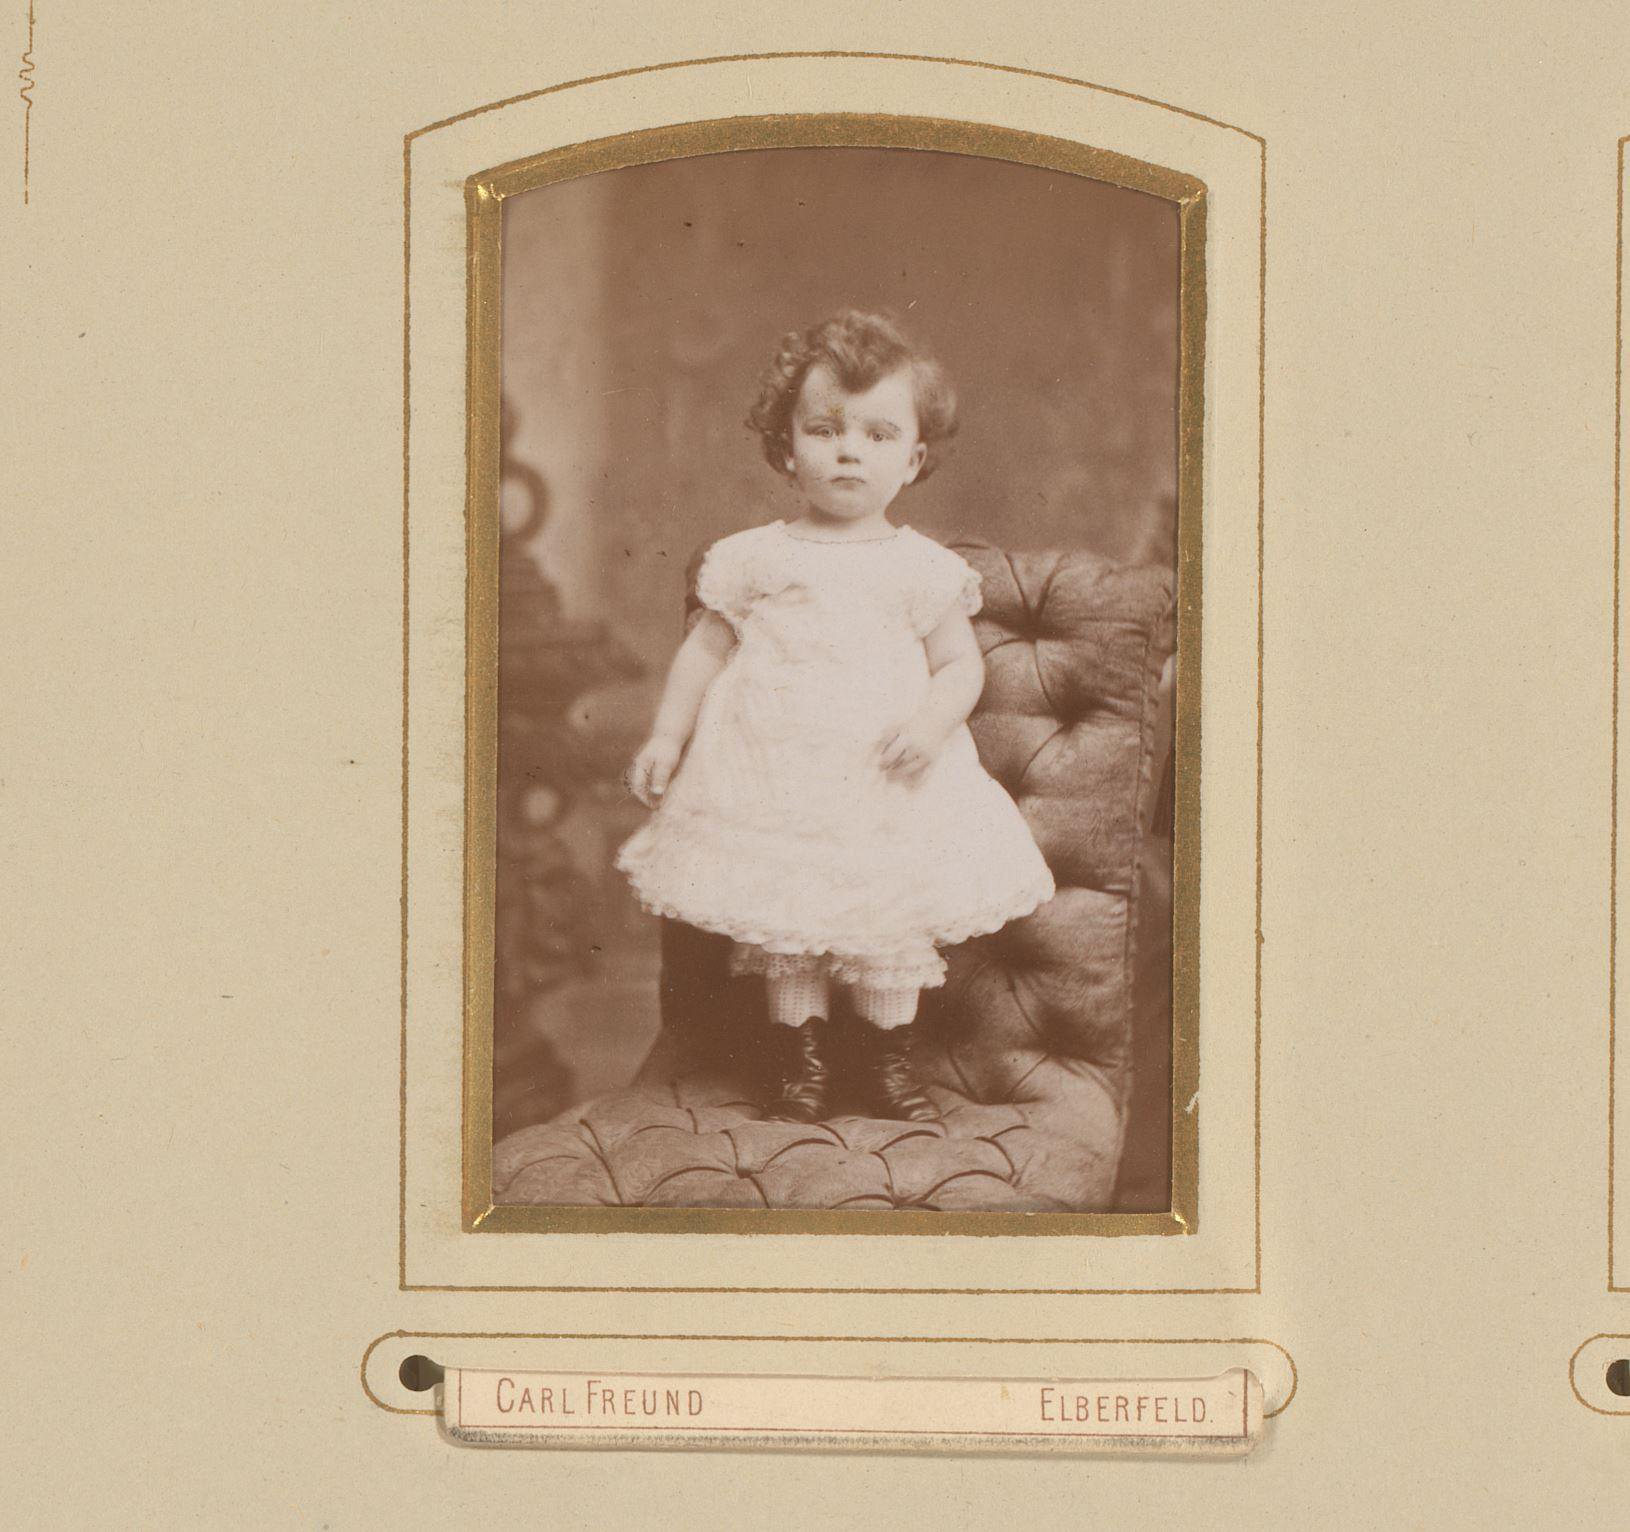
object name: photograph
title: Portret van een meisje, staand op een stoel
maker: carl freund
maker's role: fotograaf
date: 1893-1894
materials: cardboard, photographic support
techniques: albumen print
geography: elberfeld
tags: historical persons - bb - woman, toddler (female), chair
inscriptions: inscription: ‘Carl Freund/ ELBERFELD/ Hofauerstrasse 80/ gegenüber/ Hôtel Weidenhof./ Die Platte wird zum Nachbestellen aufbewahrt.’